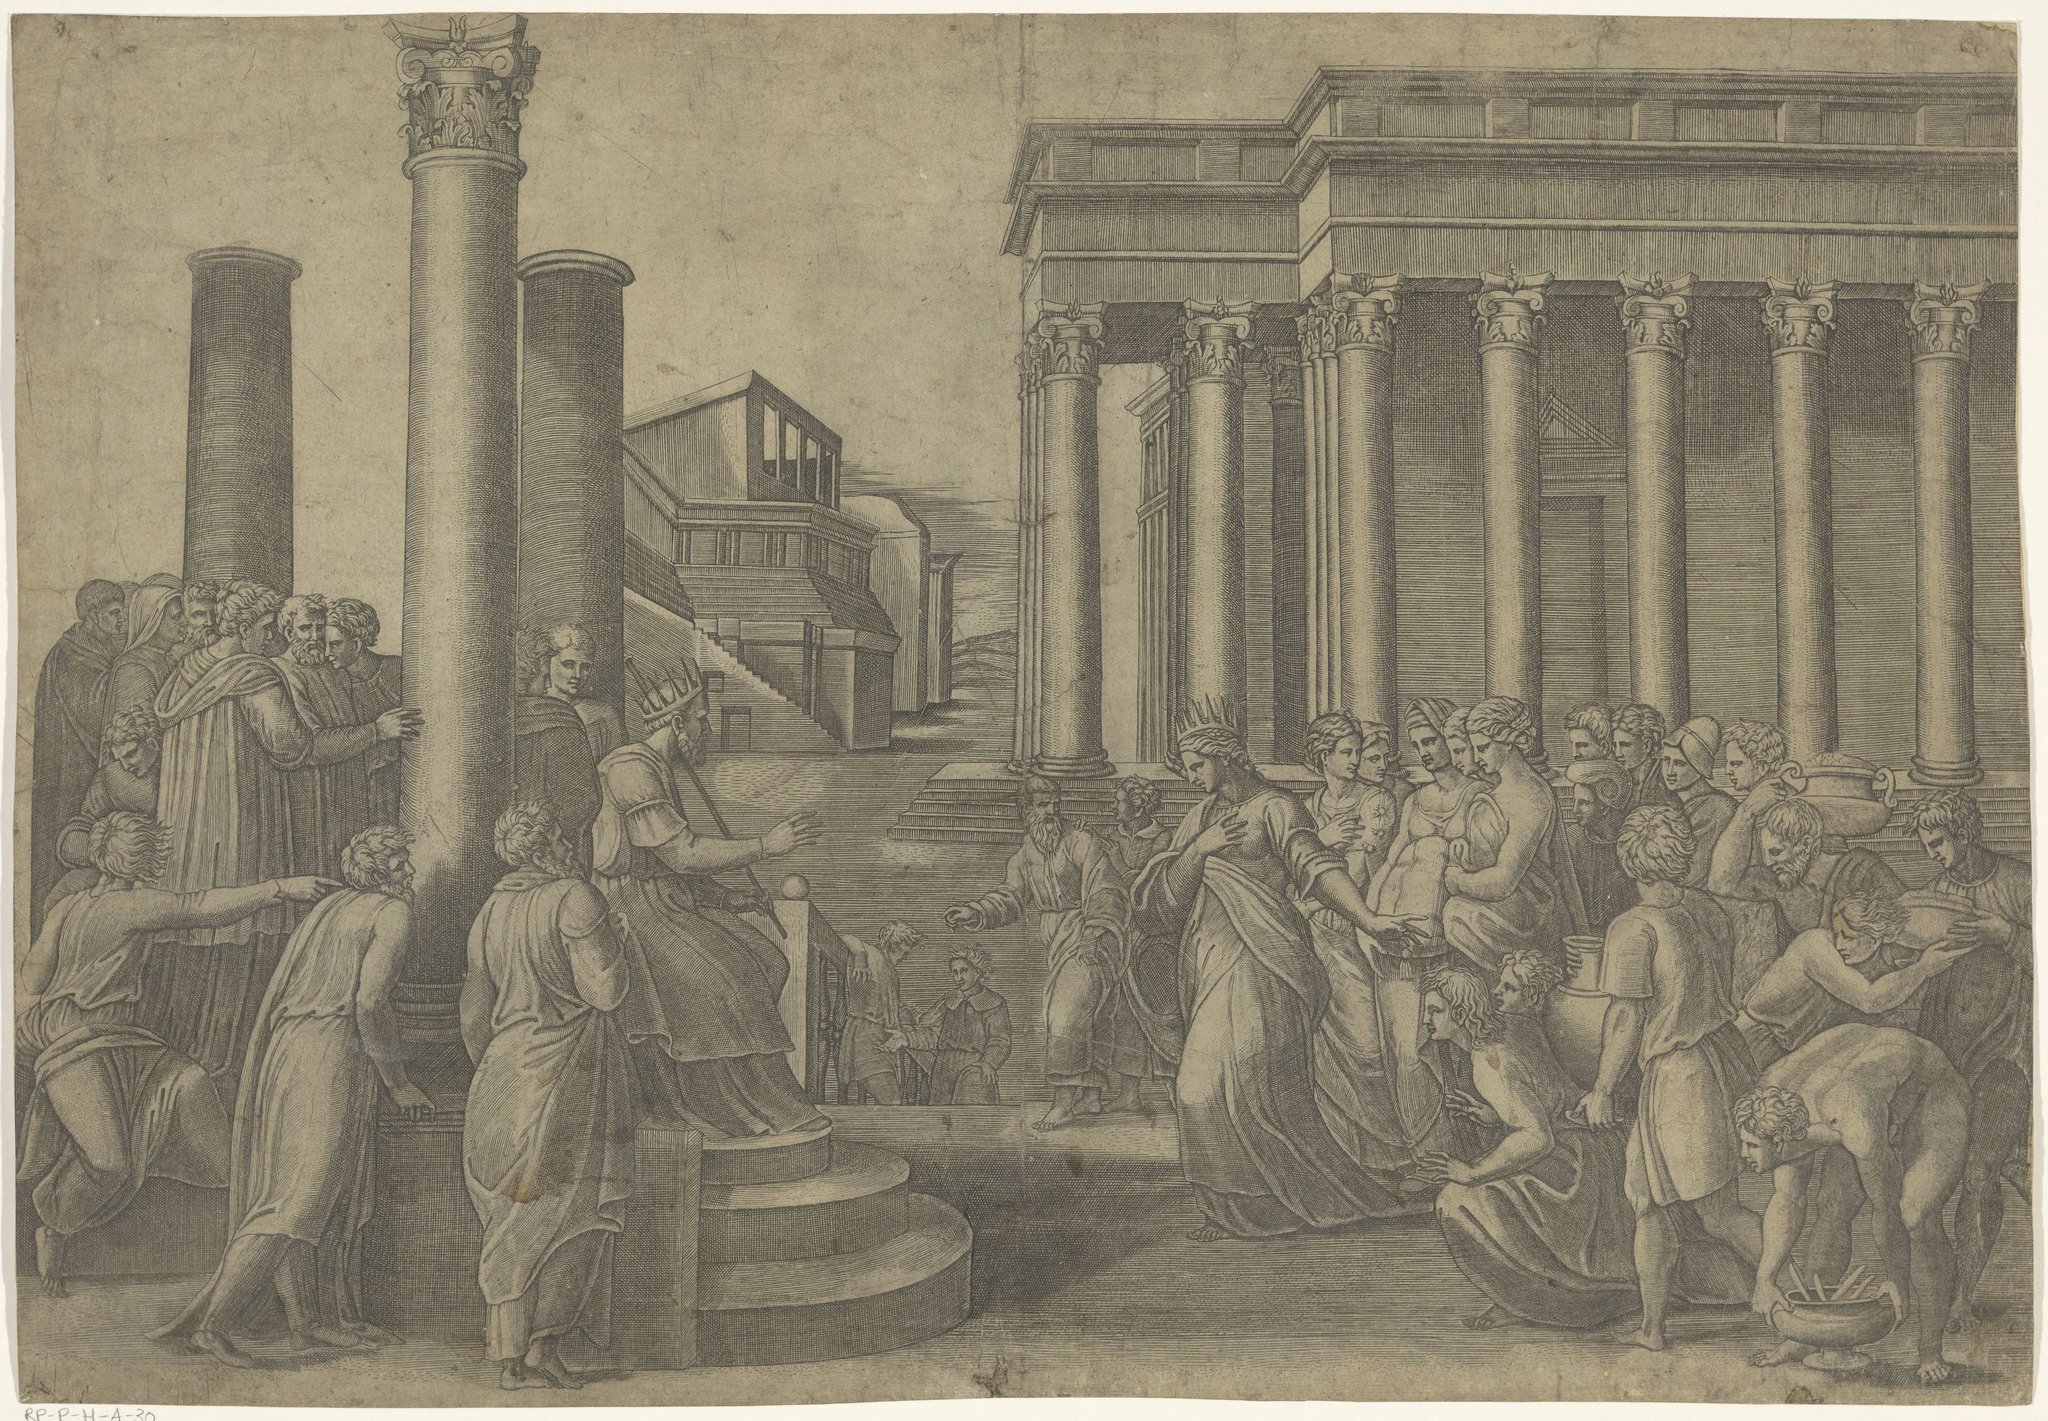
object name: print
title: Salomo en de koningin van Seba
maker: marcantonio raimondi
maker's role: print maker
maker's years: 1470-1534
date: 1490-1527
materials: paper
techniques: engraving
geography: italy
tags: solomon and the queen of sheba (1 kings 10:1-3; 2 chronicles 9:1-9)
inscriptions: collector's mark: ‘Hinloopen’, collector's mark: Lugt 11, collector's mark: Lugt 10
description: De koningin van Seba staat met haar vrouwelijke metgezellinnen voor koning Salomo en zijn mannelijke gevolg. Op de achtergrond de Tempel van Salomo.